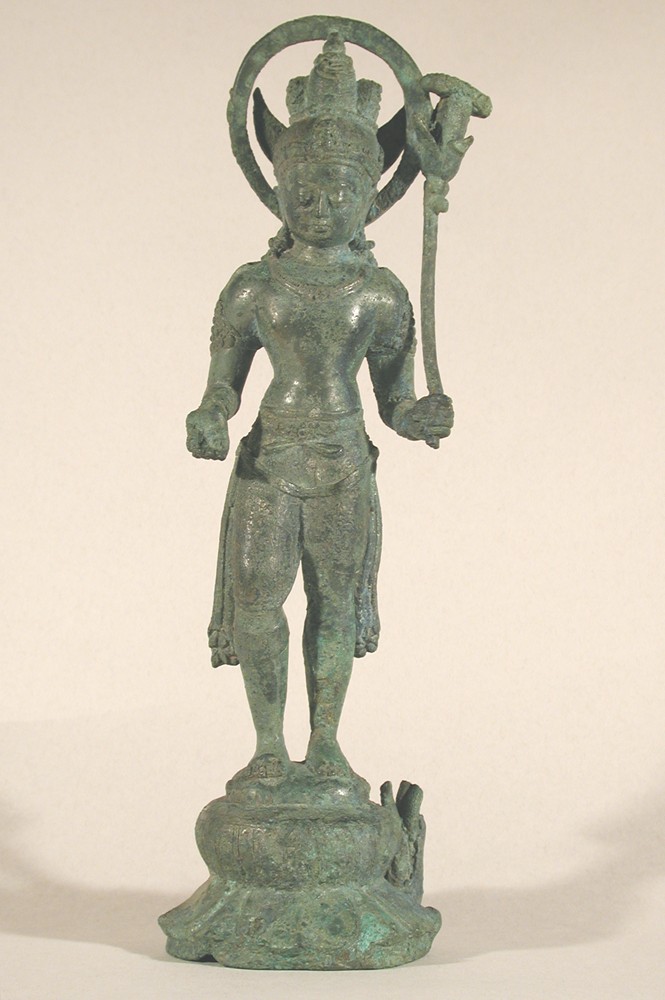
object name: figure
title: Standing Manjushri, the Bodhisattva of Infinite Wisdom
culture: indonesian, javanese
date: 834-866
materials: bronze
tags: buddhism,bodhisattvas,manjushri